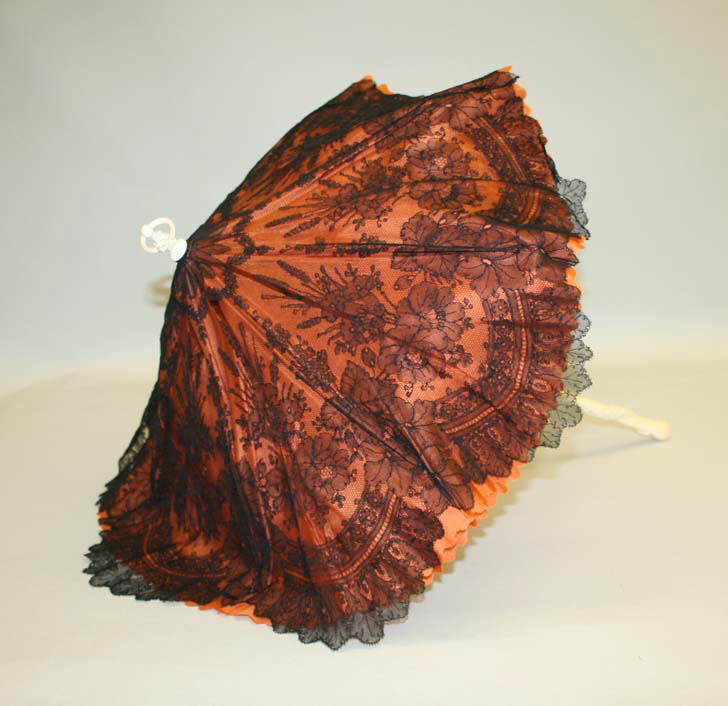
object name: parasol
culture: french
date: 1860-1869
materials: ivory, metal, silk